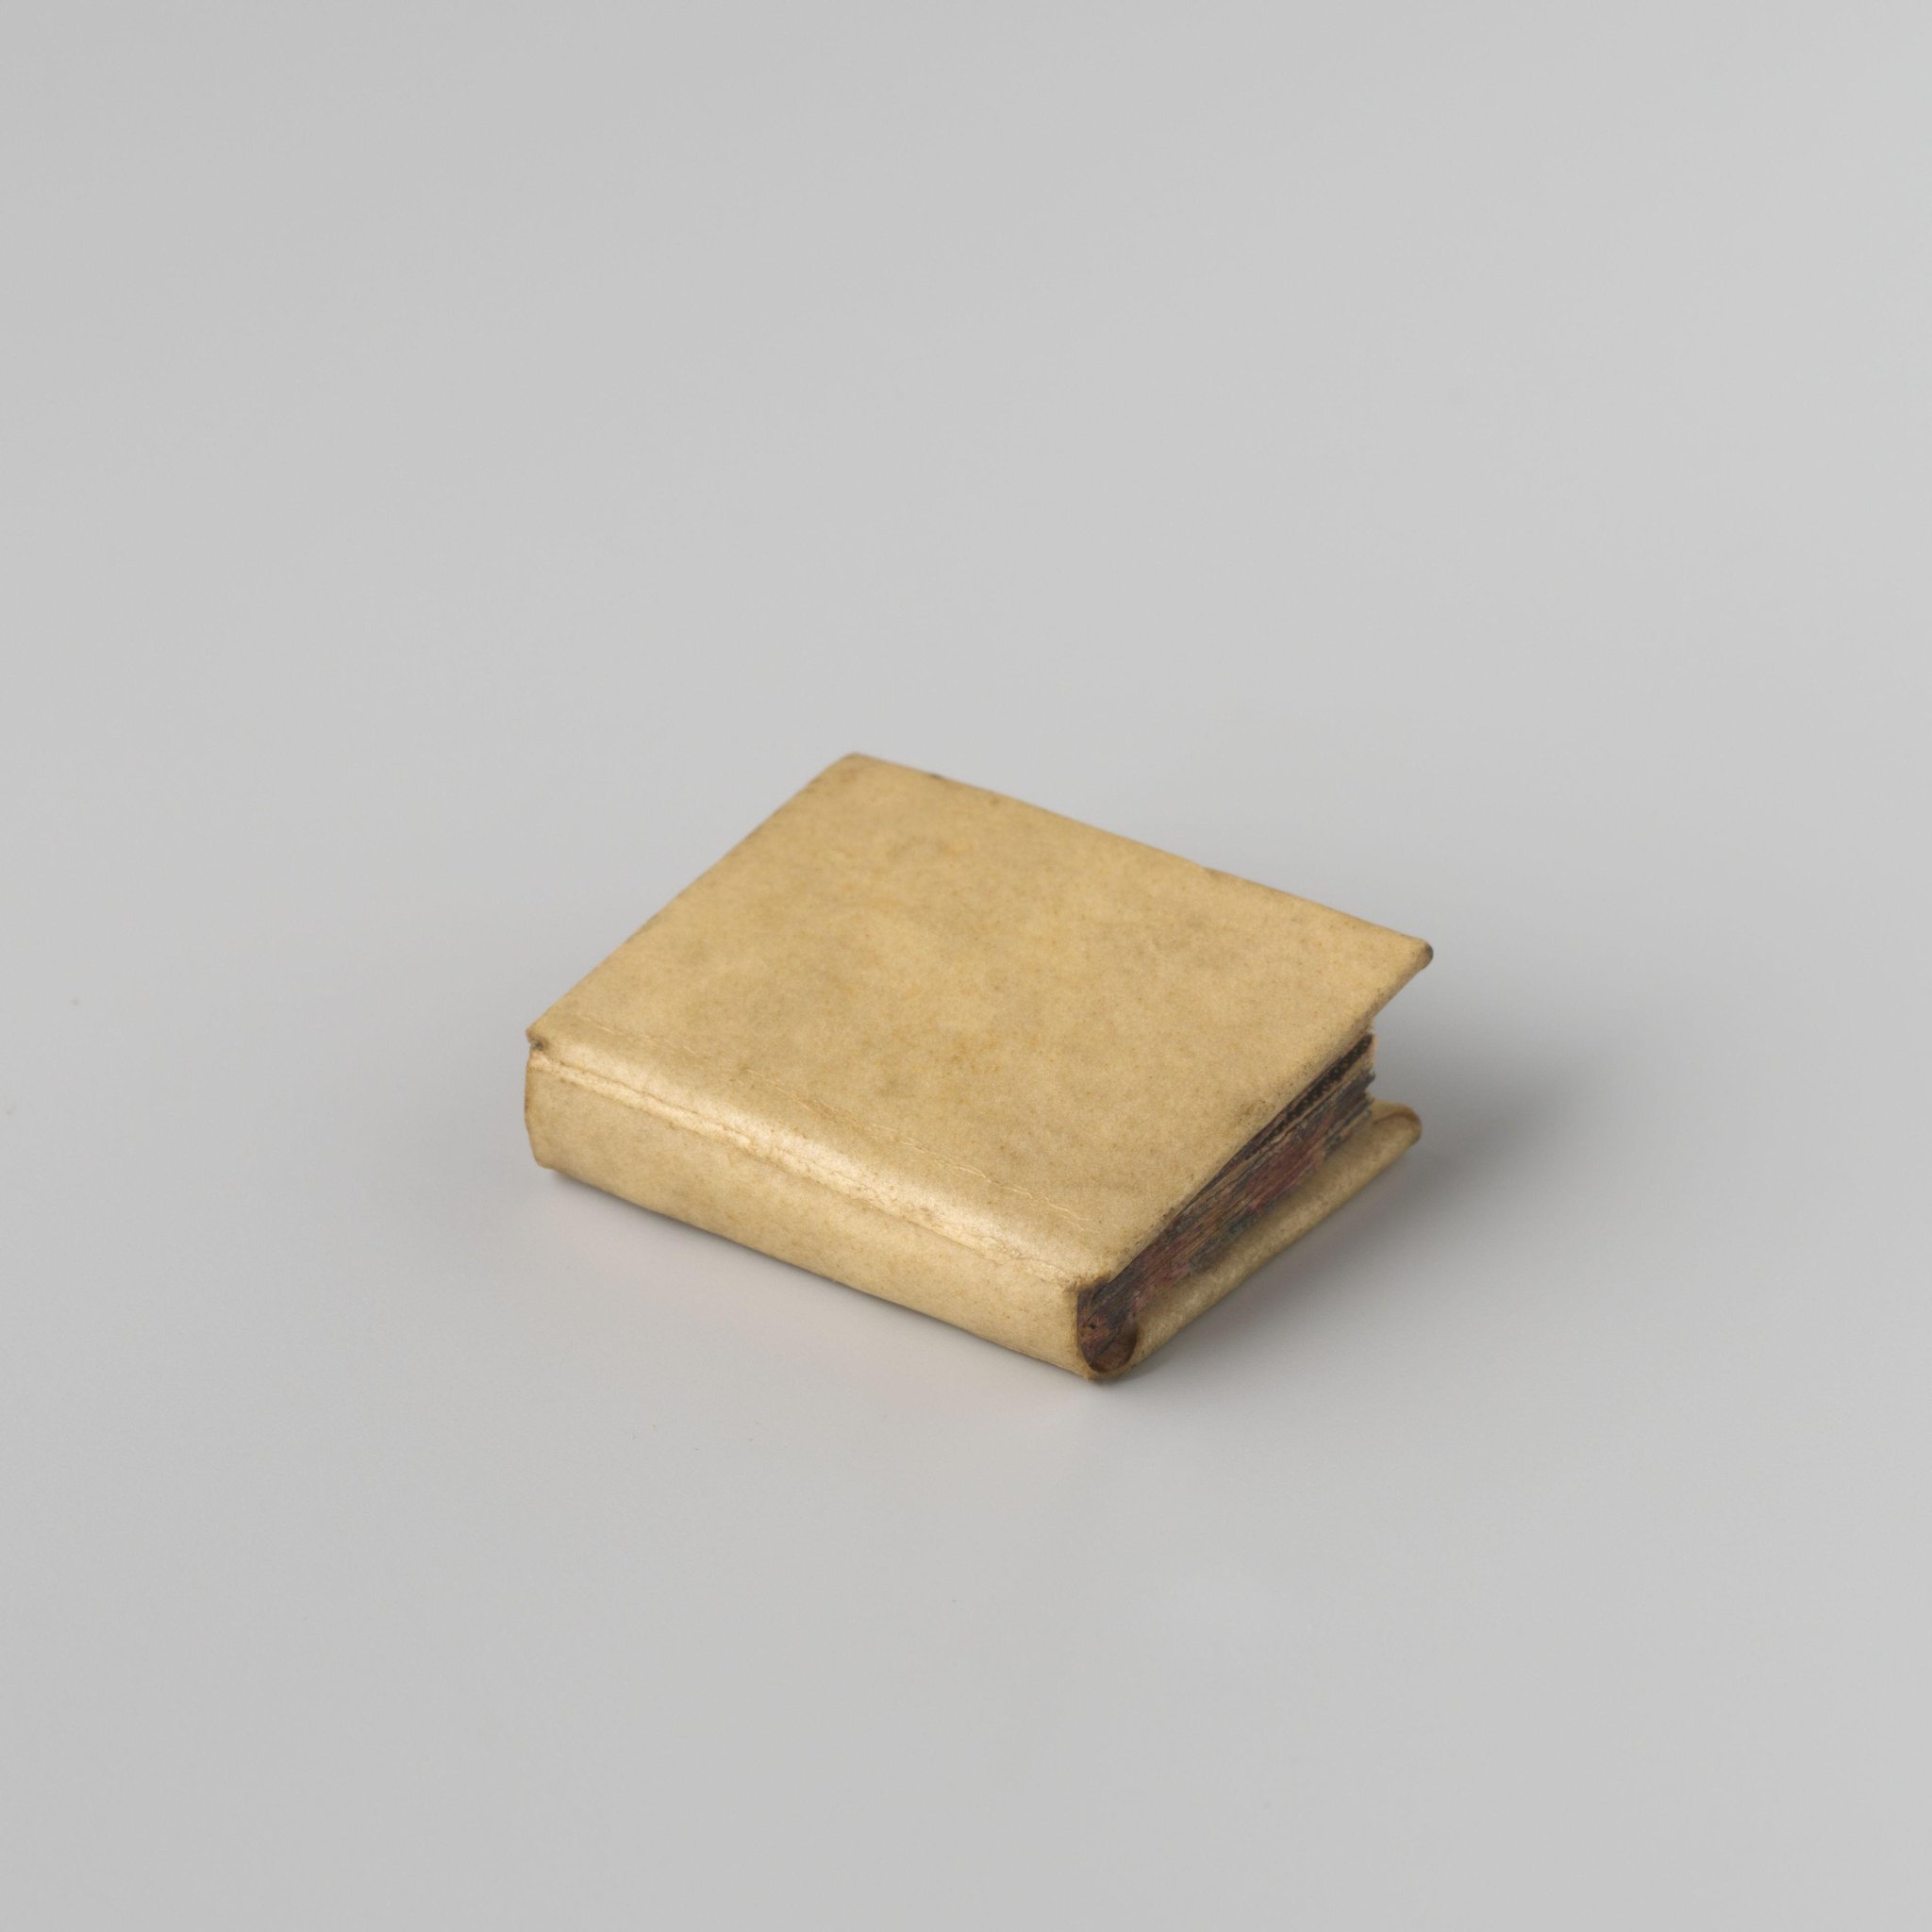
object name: book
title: Boek met figuren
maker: Anonymous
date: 1690-1710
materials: leather, paper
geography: amsterdam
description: Boek met figuren. Ingebonden in blank perkament.